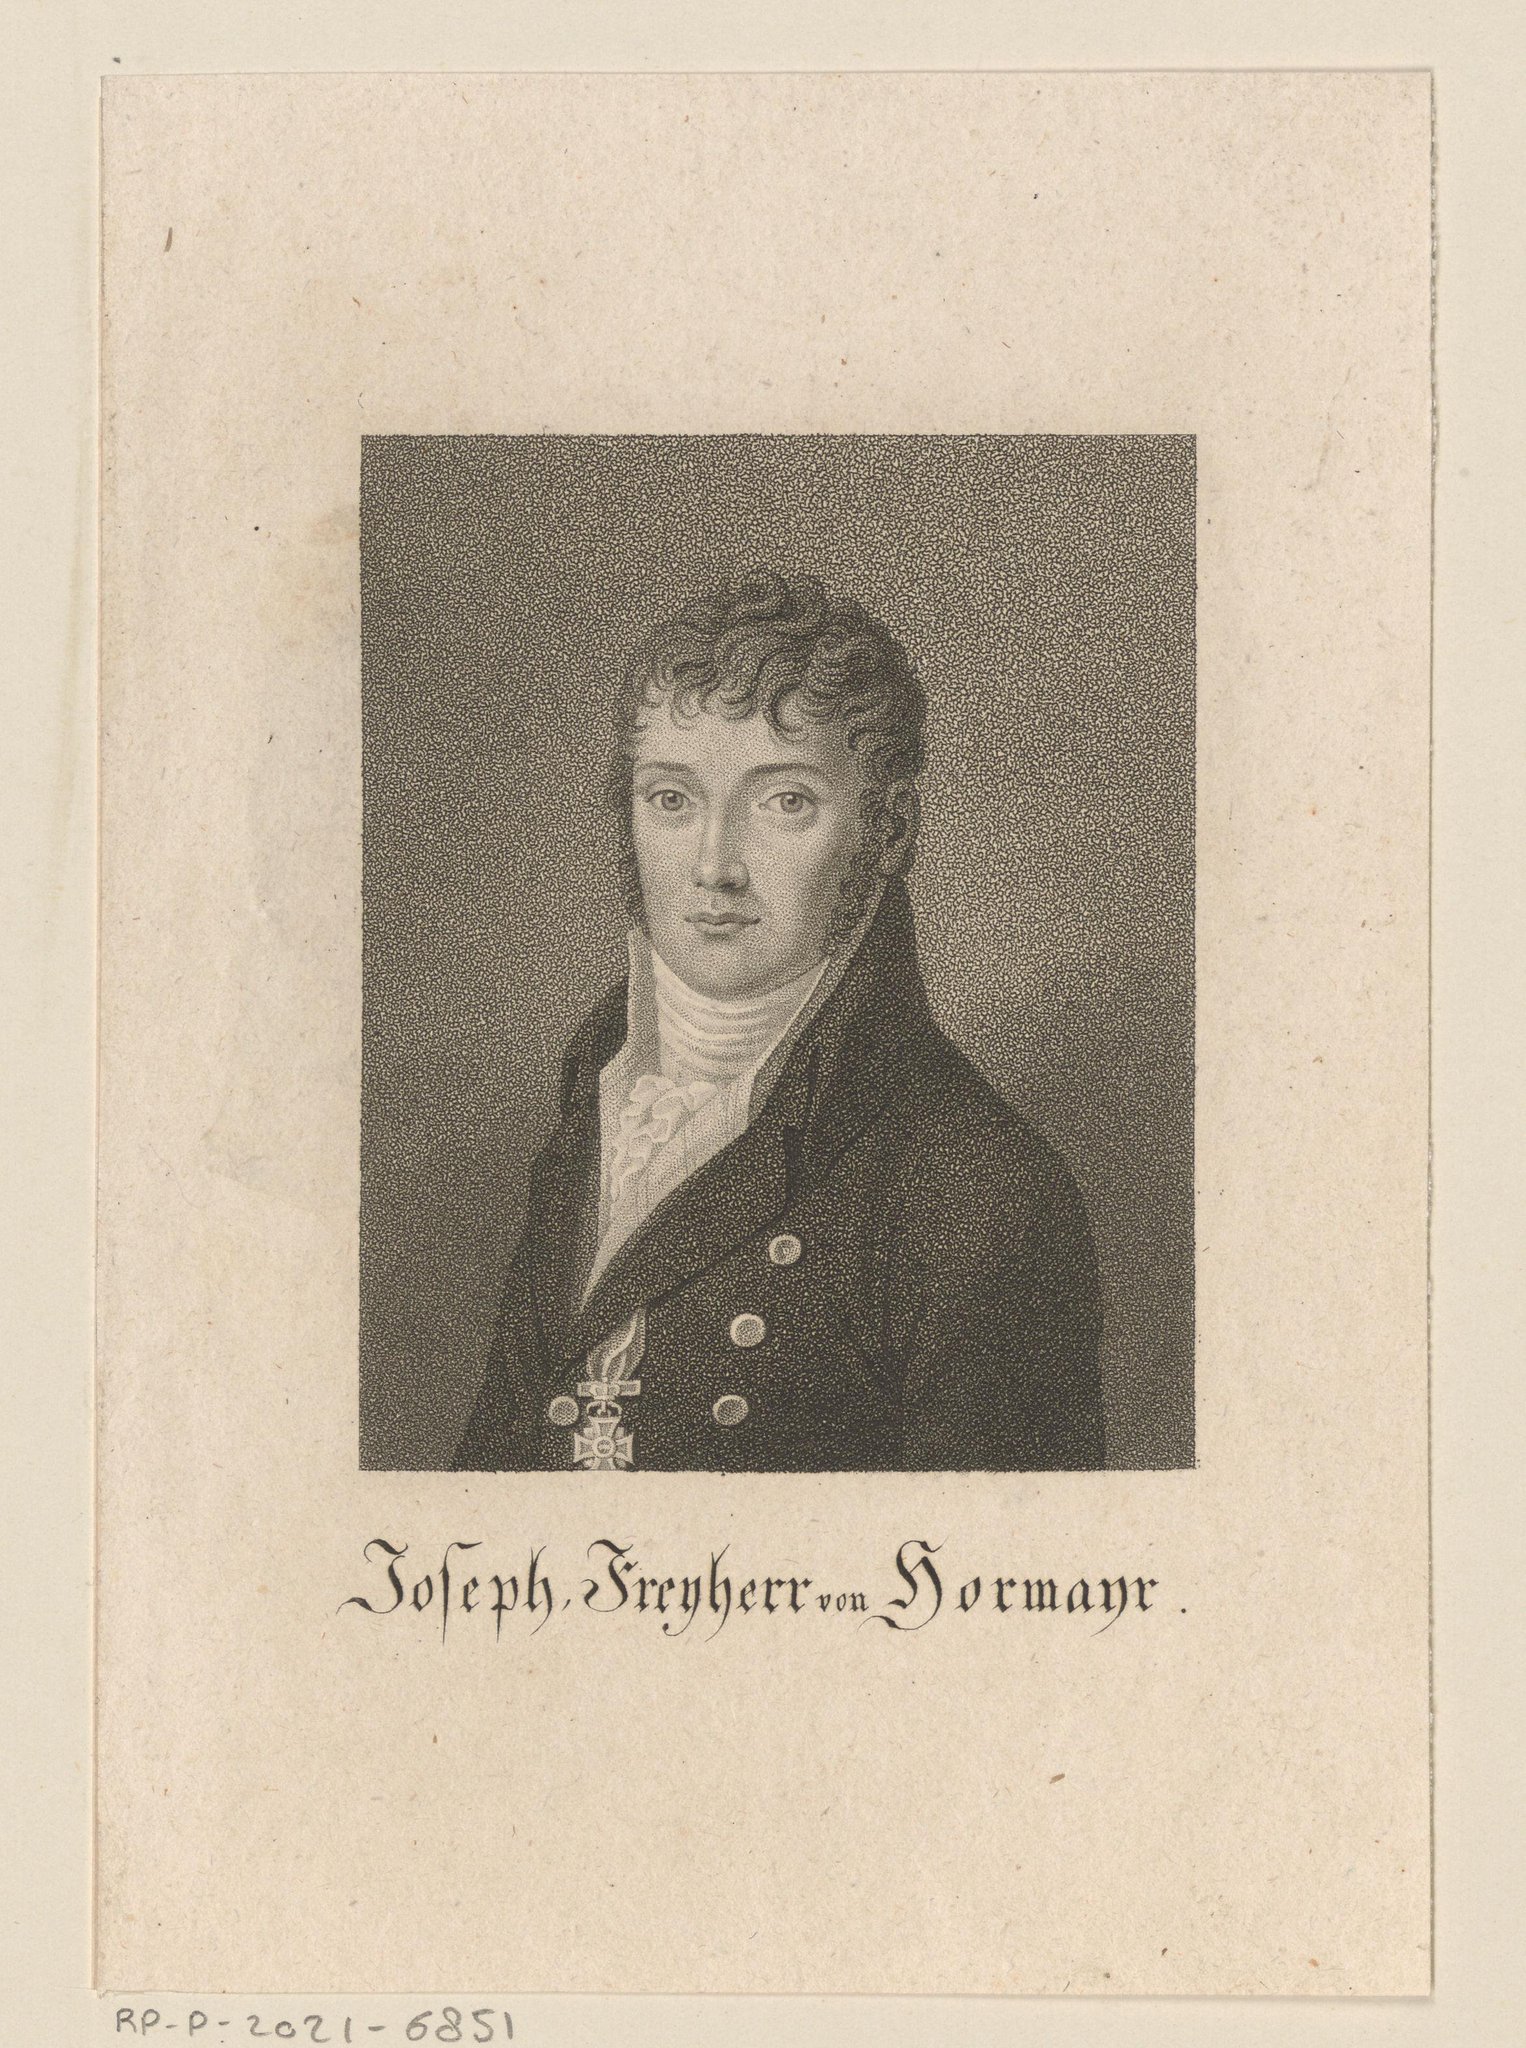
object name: print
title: Portret van Joseph von Hormayr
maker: Anonymous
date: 1820-1850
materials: paper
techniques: etching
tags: historical persons, portrait of a writer